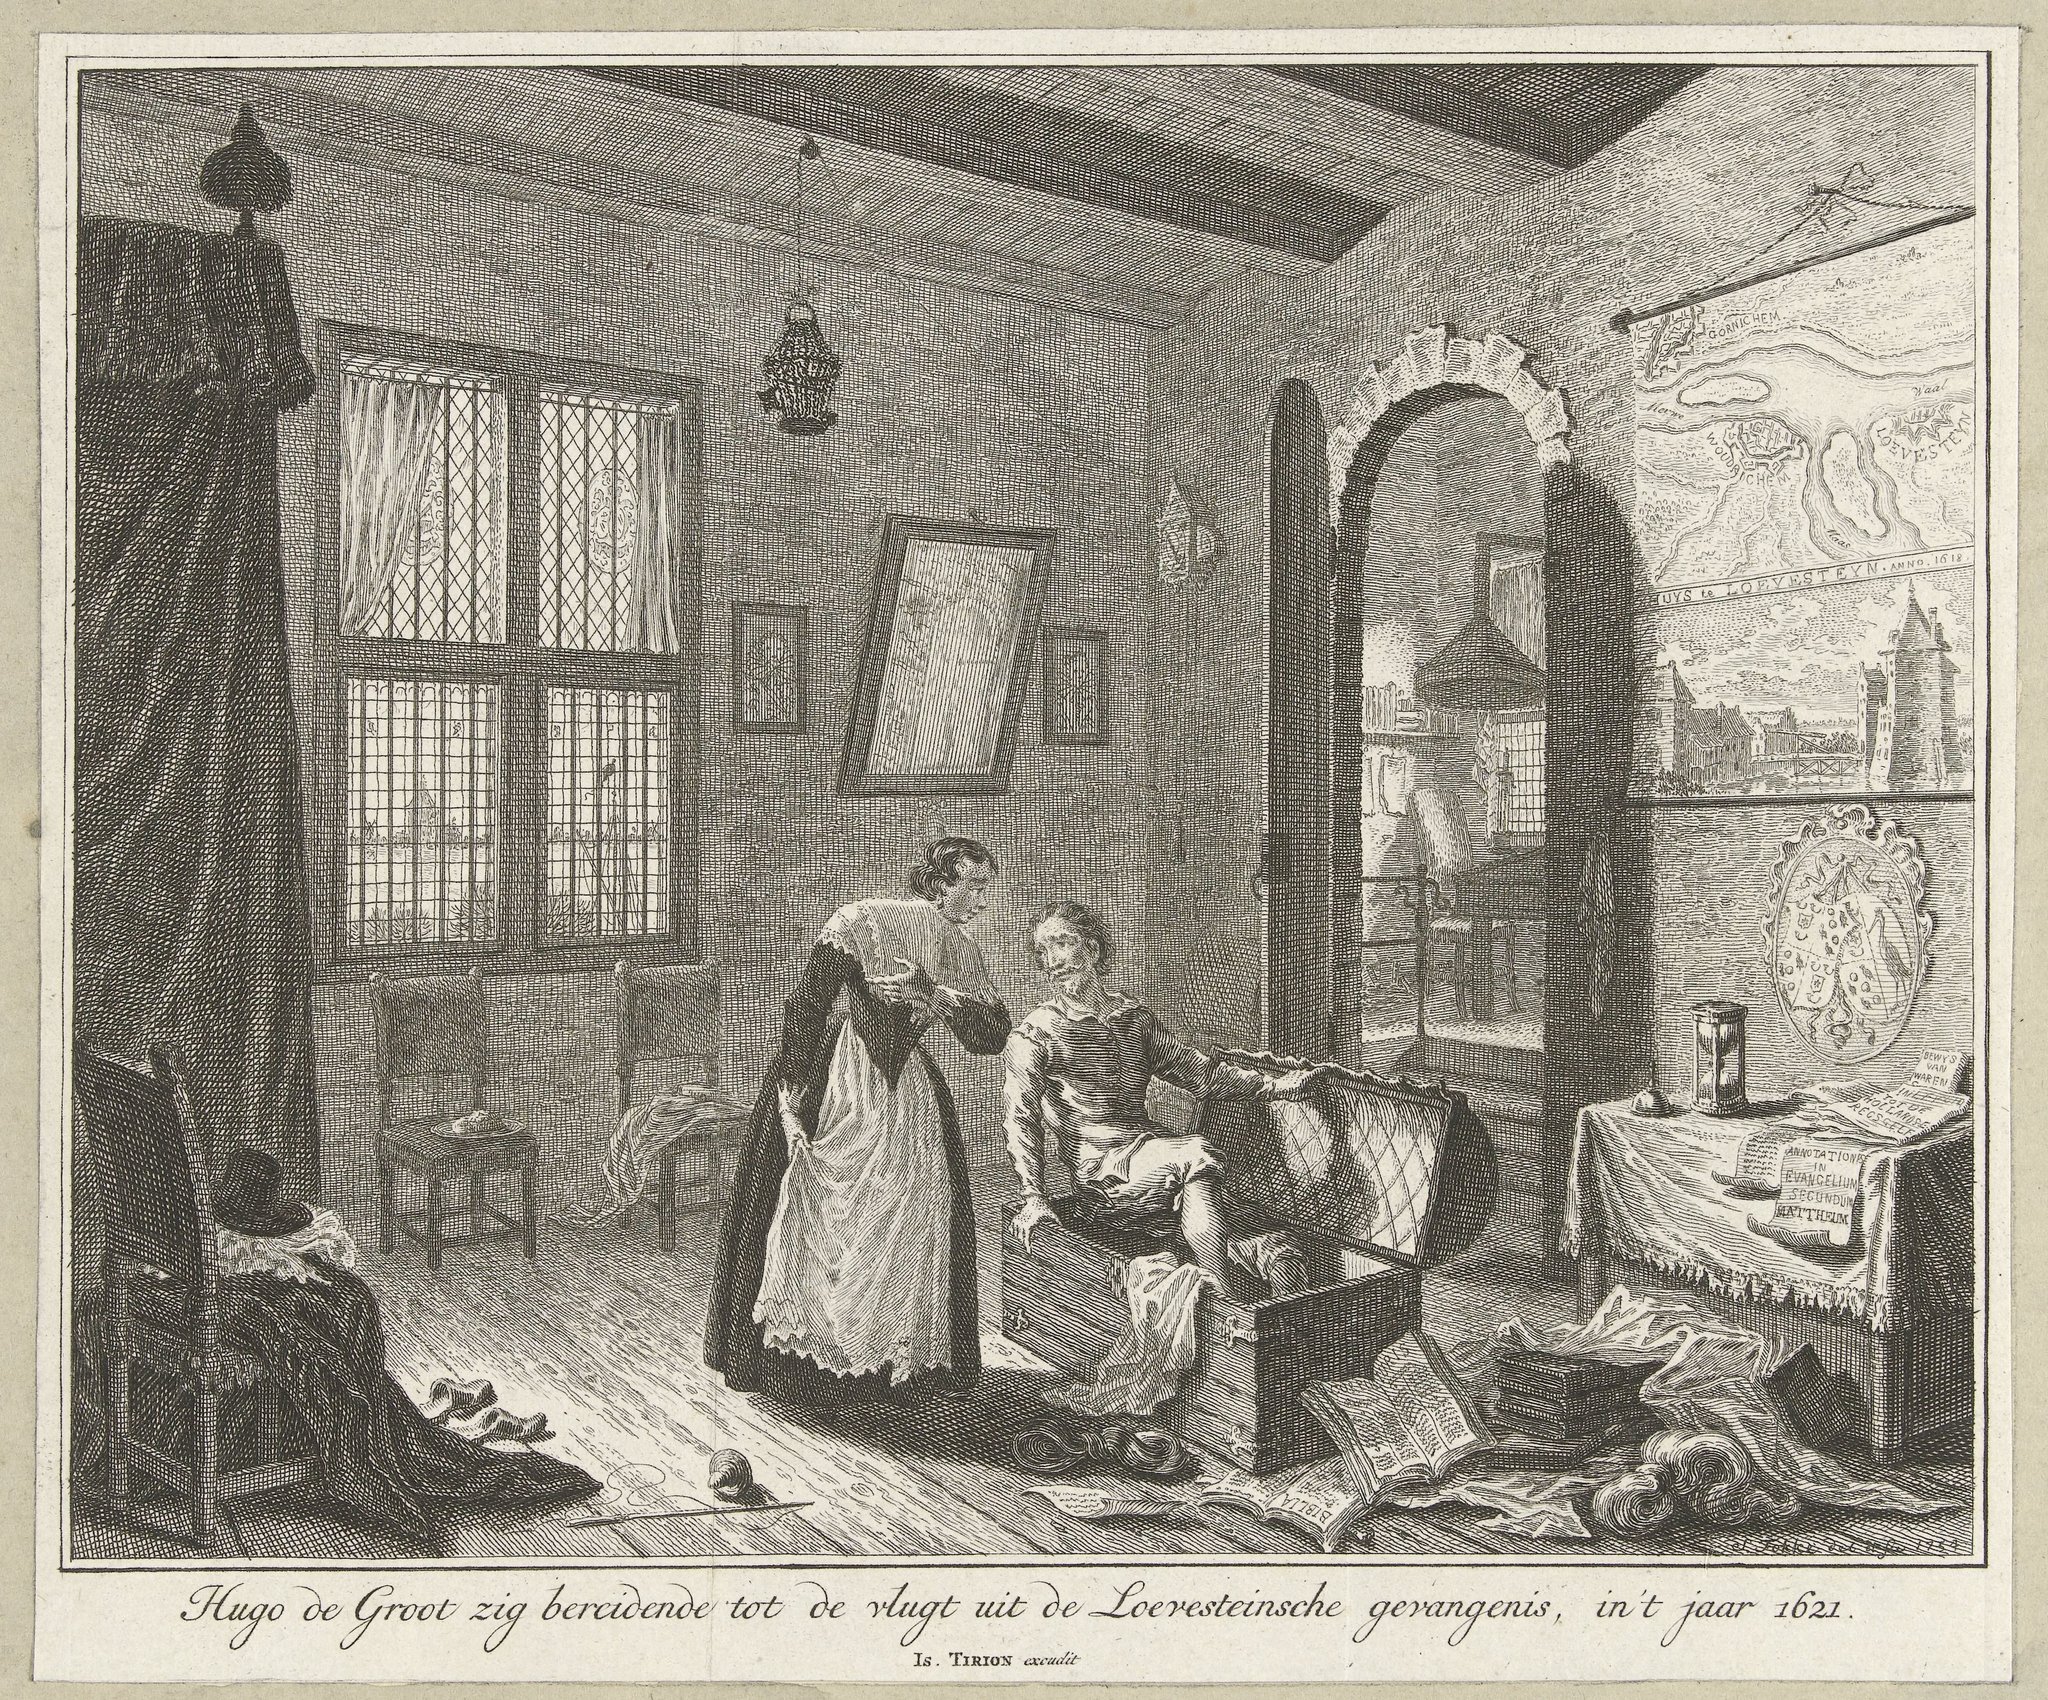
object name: print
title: Hugo de Groot bereidt zich voor op de vlucht uit slot Loevestein, 1621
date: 1754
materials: paper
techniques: etching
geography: amsterdam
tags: delft, hugo de groot, law and jurisprudence (+ escape from prison), loevestein castle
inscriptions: collector's mark: Lugt 2228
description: In een vertrek stapt Hugo de Groot in een boekenkist. Naast hem staat zijn echtgenote Maria van Reigersberch, die het plan voor de ontsnapping met de boekenkist had bedacht. Aan de muur een prent, op tafel en op de grond boeken en manuscripten.